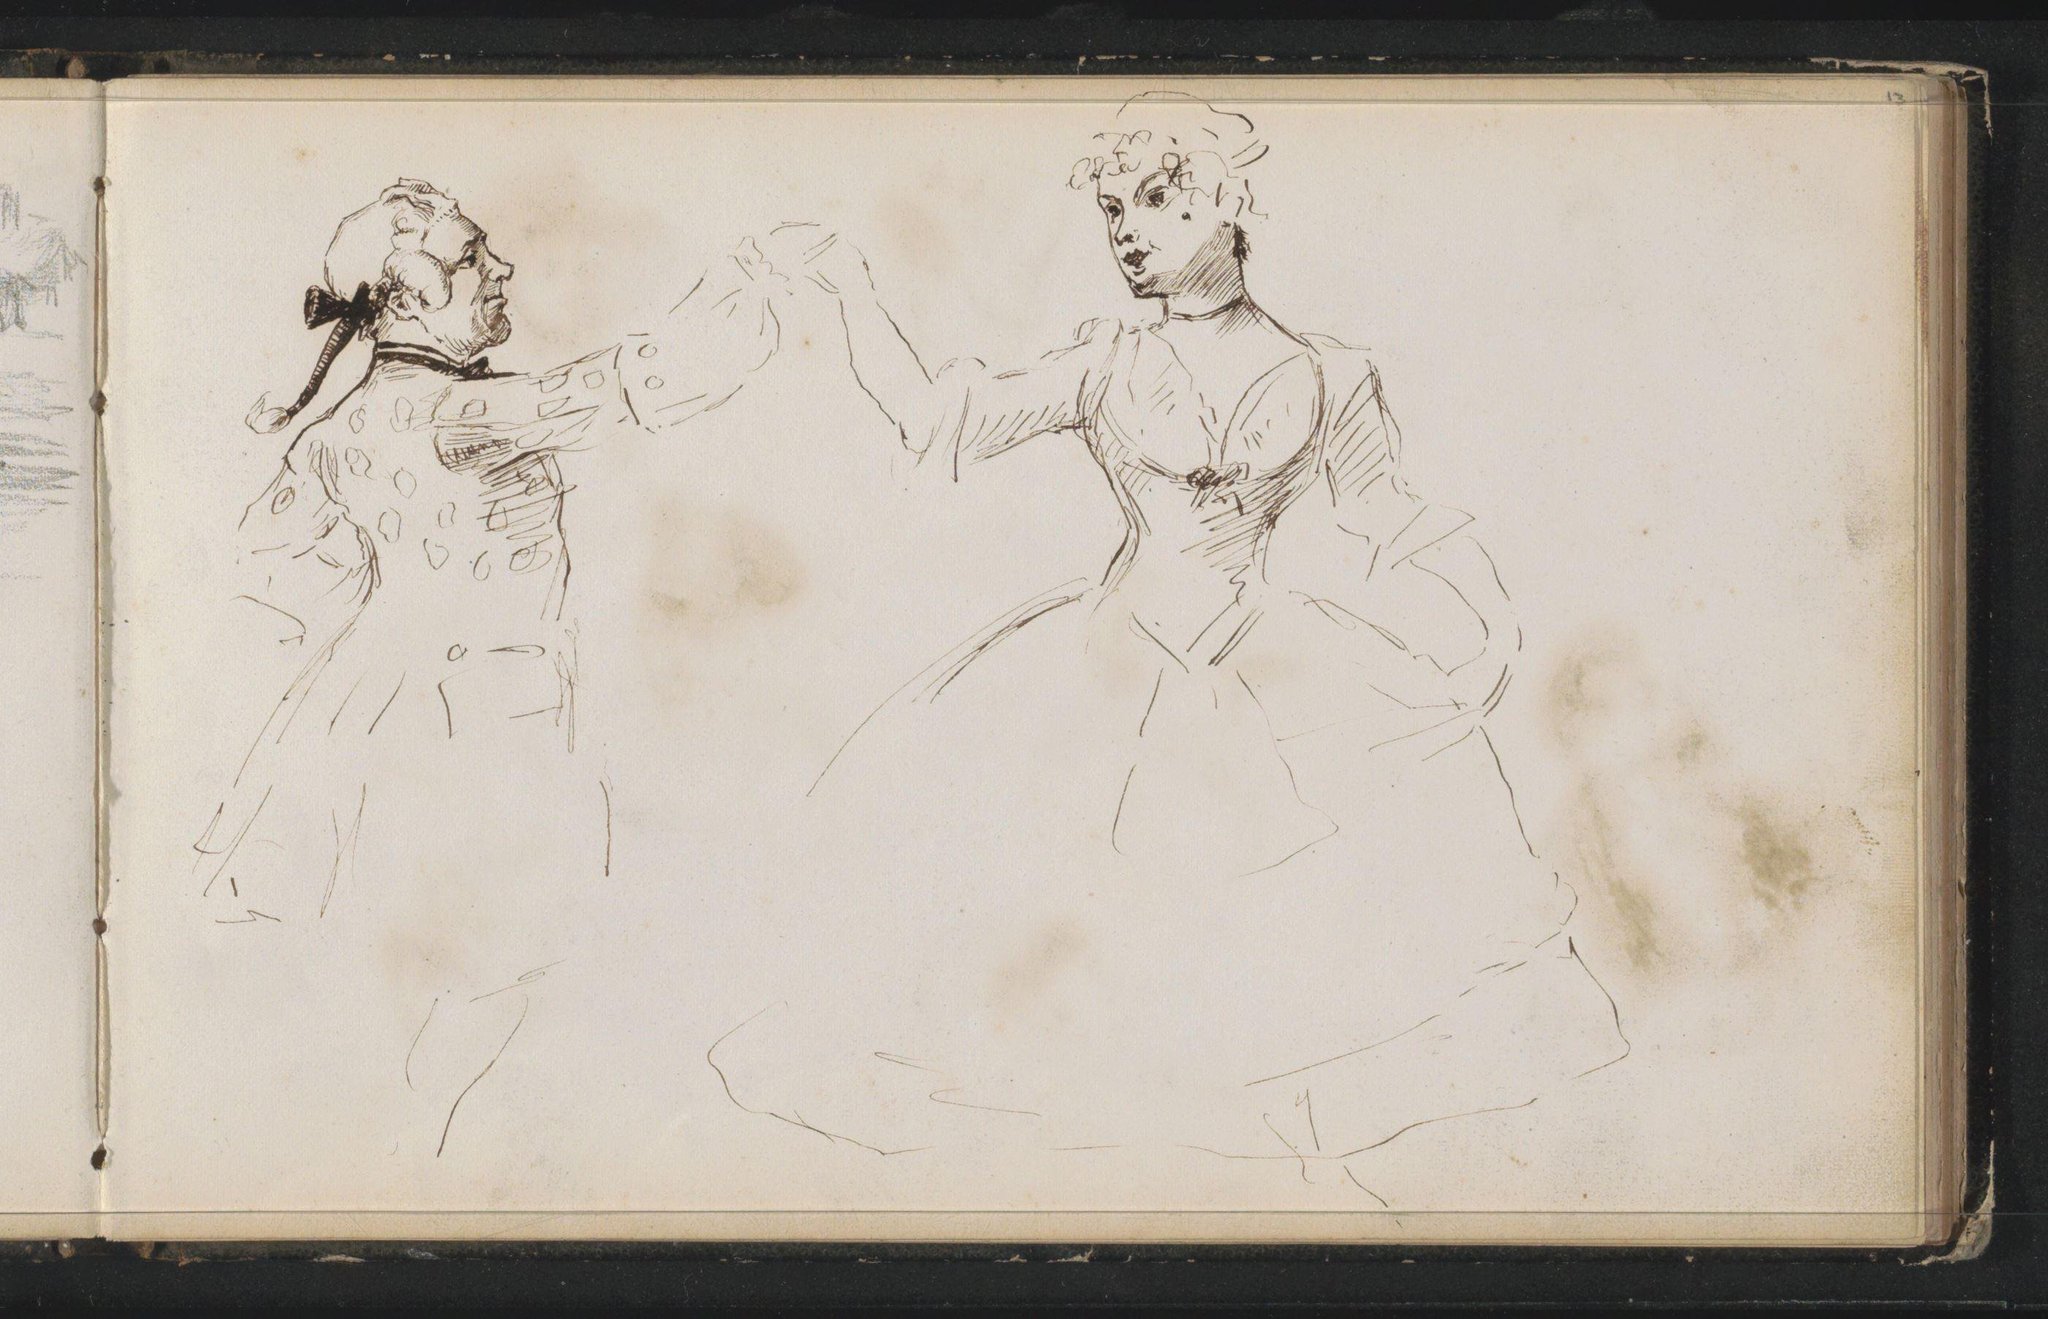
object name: sketchbook leaf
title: Dansend paar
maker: marius bauer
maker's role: draughtsman, print maker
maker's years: 1867-1932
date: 1812-1880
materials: paper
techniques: pen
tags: adult woman, adult man, one pair dancing; man and woman dancing as a couple, historical costume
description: De man en vrouw dragen achttiende-eeuws kostuum. Pagina 13 uit een schetsboek met 34 bladen.